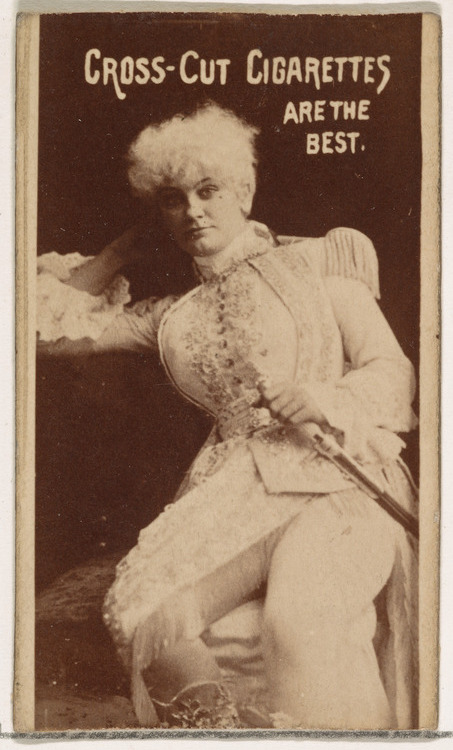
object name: print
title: Actress wearing costume with white wig and sword, from the Actors and Actresses series (N145-1) issued by Duke Sons & Co. to promote Cross Cut Cigarettes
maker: w. duke, sons & co.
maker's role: publisher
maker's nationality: american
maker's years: 1870-1920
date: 1880-1889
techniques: albumen silver print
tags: portraits,women,actresses